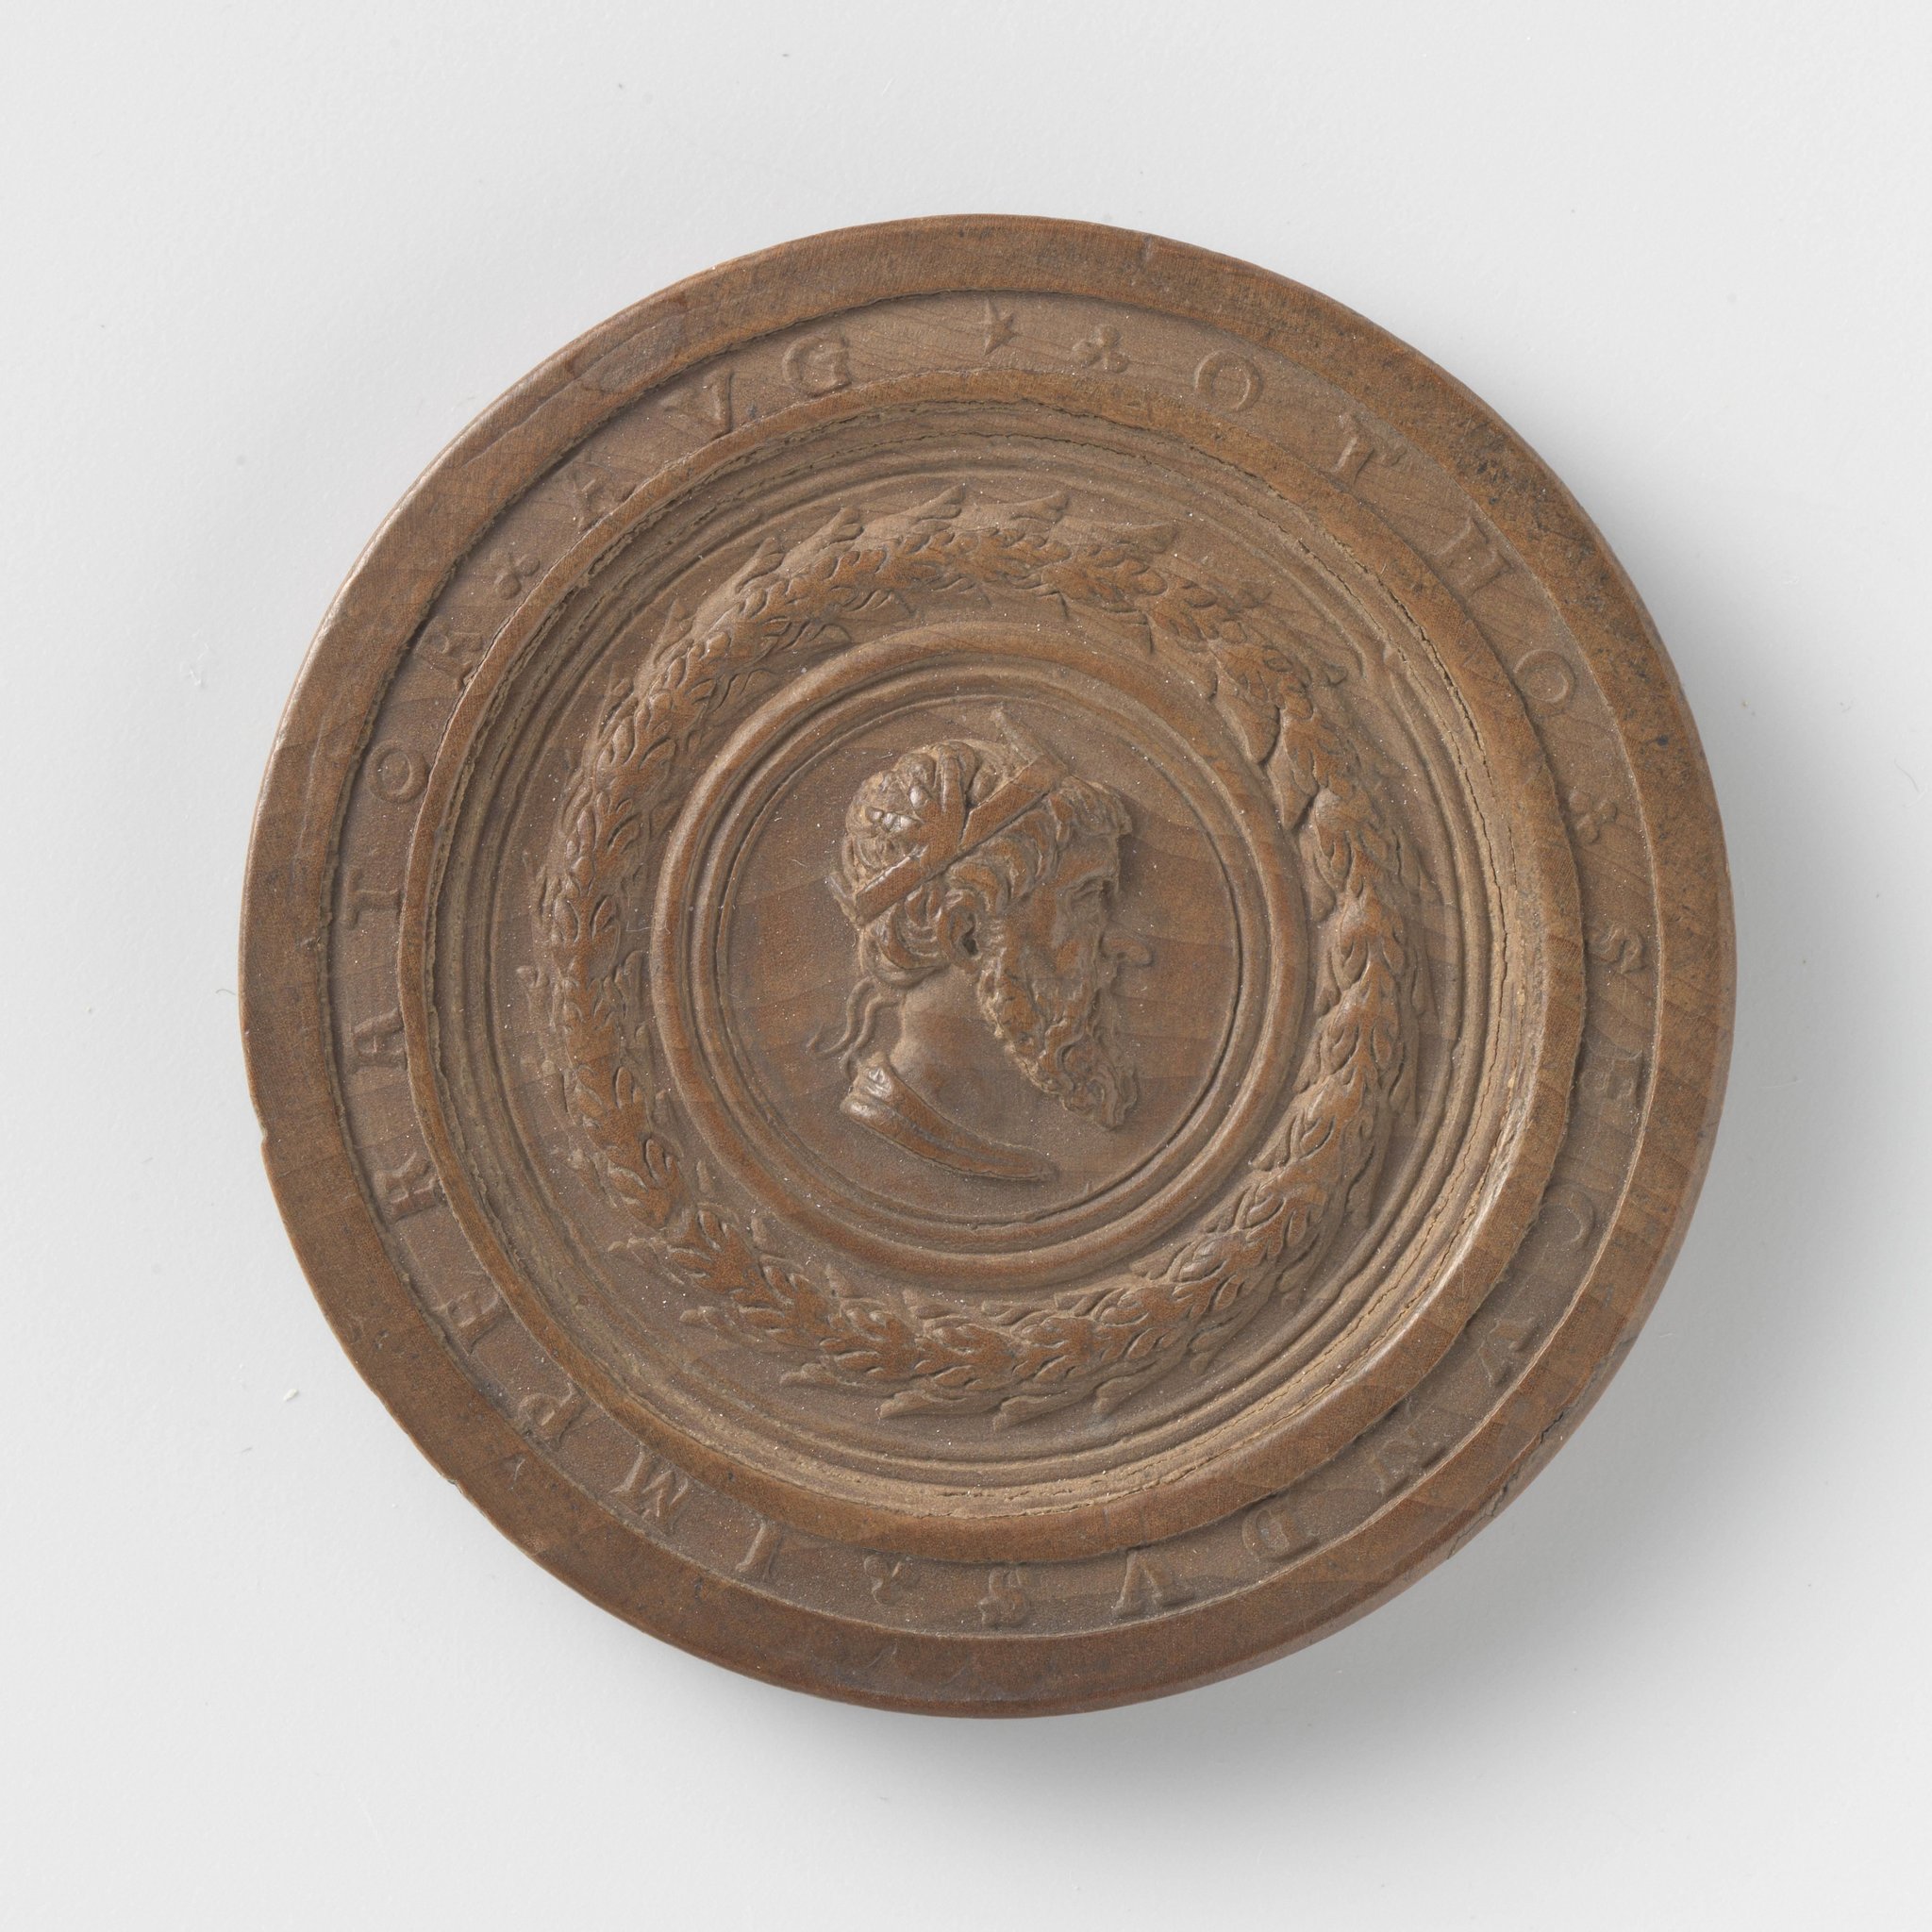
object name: checker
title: Helft van damschijf met portret: Keizer Otto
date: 1525-1575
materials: wood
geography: nuremberg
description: OTHO. SECVNDVS. IMPERATOR. AVG (Otto II (955-983), Duits keizer)